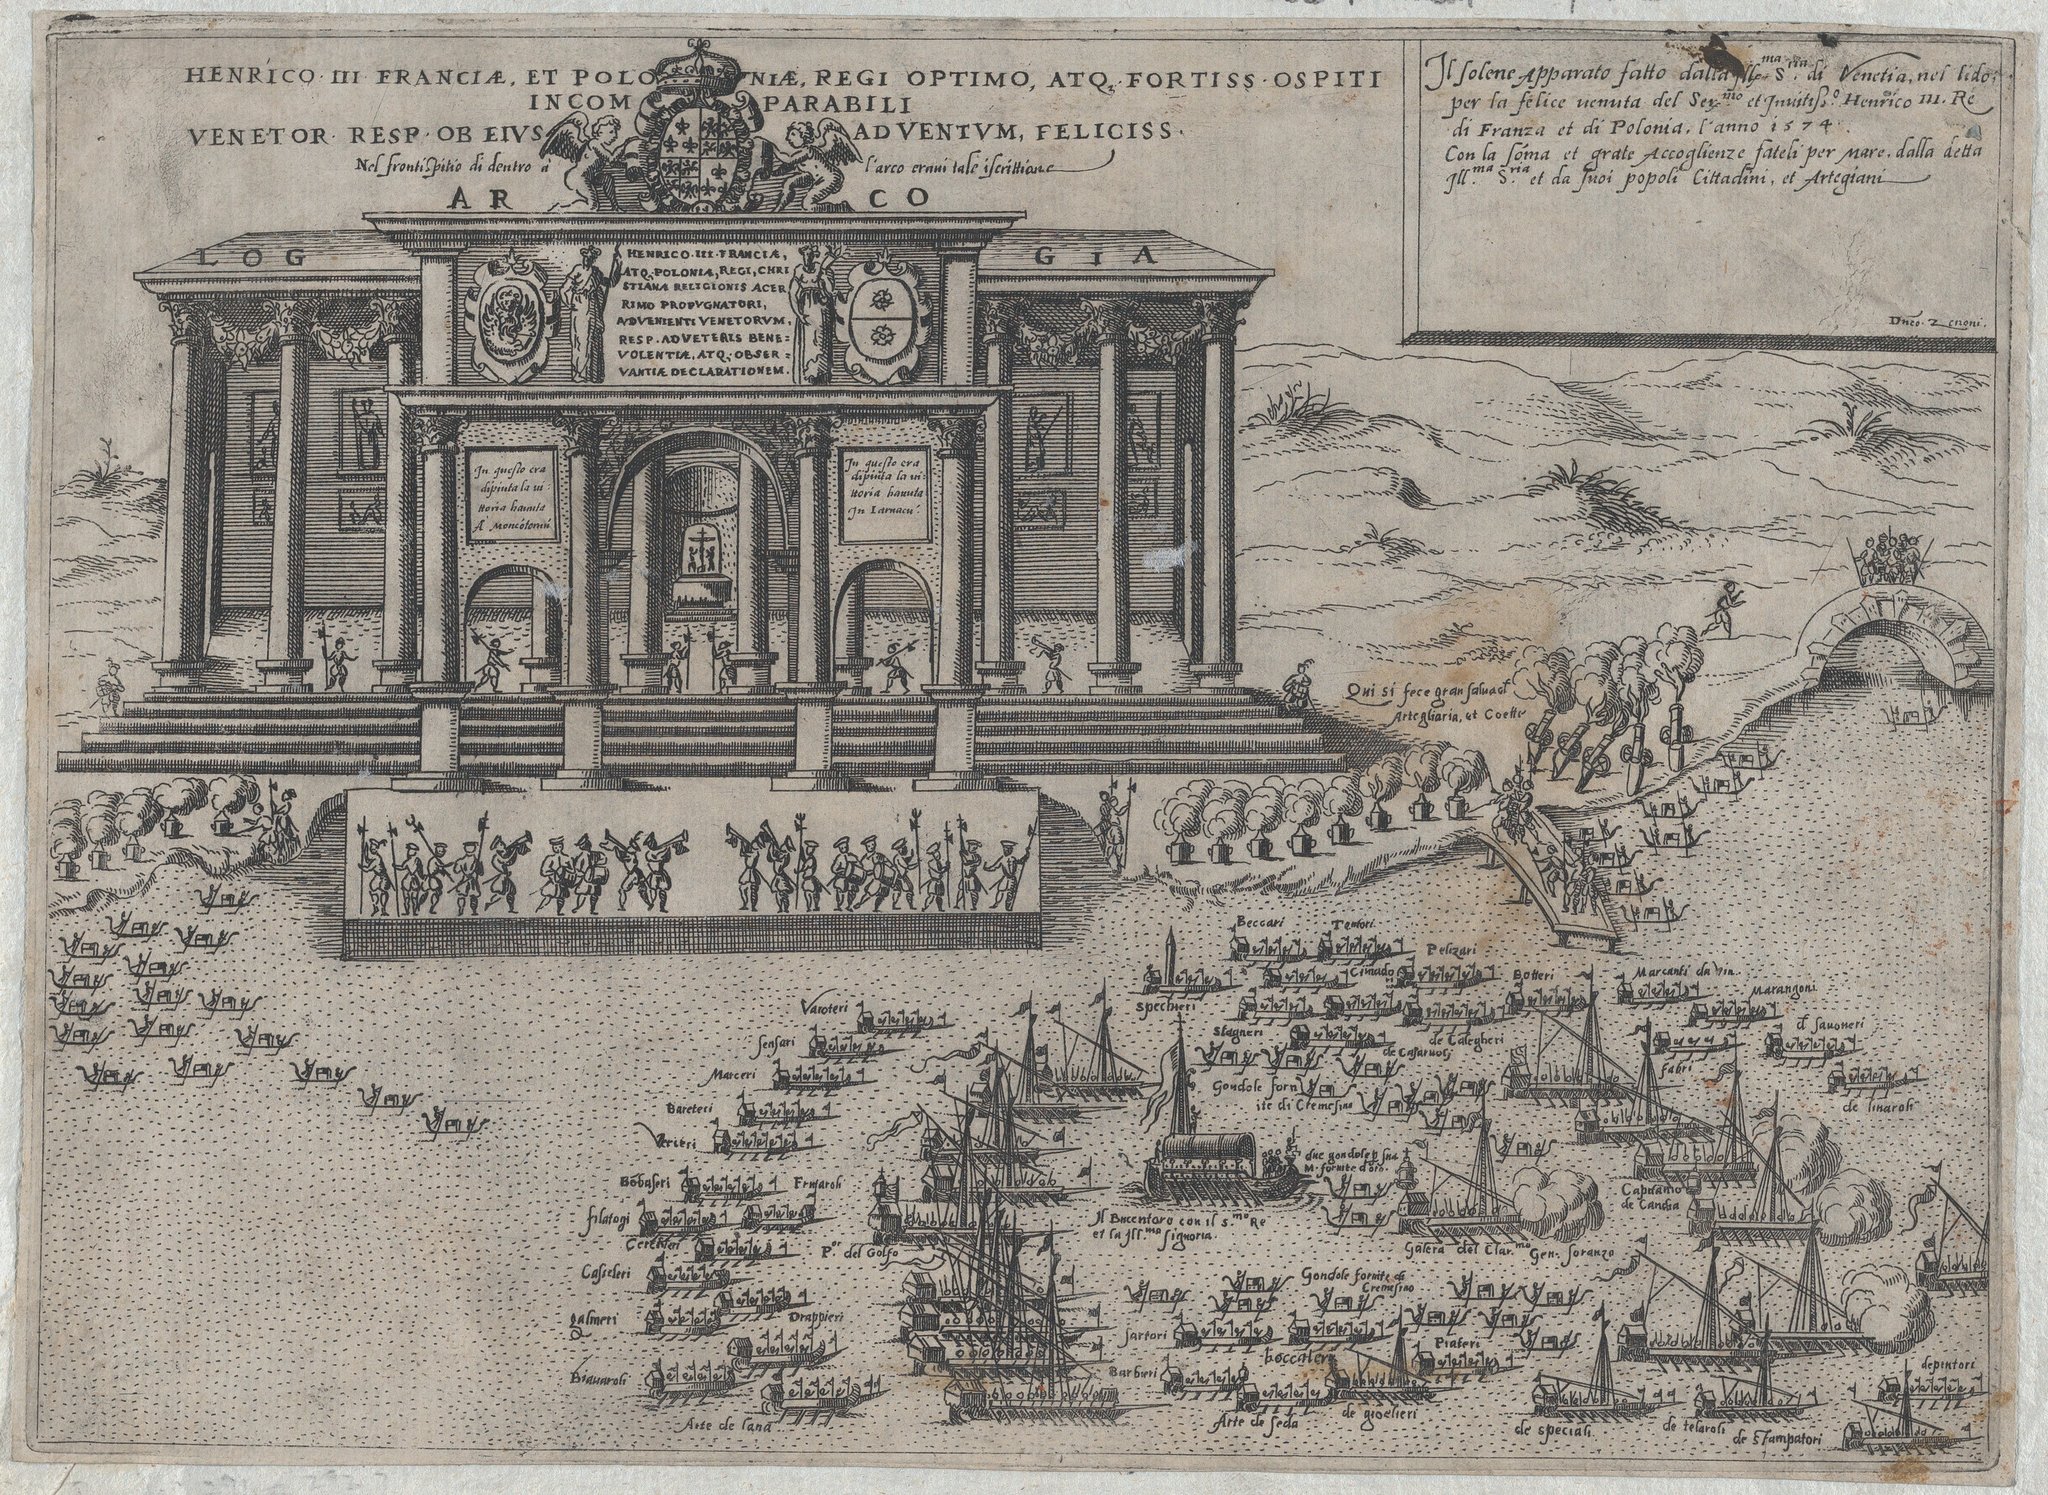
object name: print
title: Entry of Henri III, King of France and Poland, into Venice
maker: domenico zenoi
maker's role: artist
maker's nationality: italian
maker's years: 1559-1574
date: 1574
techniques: etching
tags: buildings,ships,venice